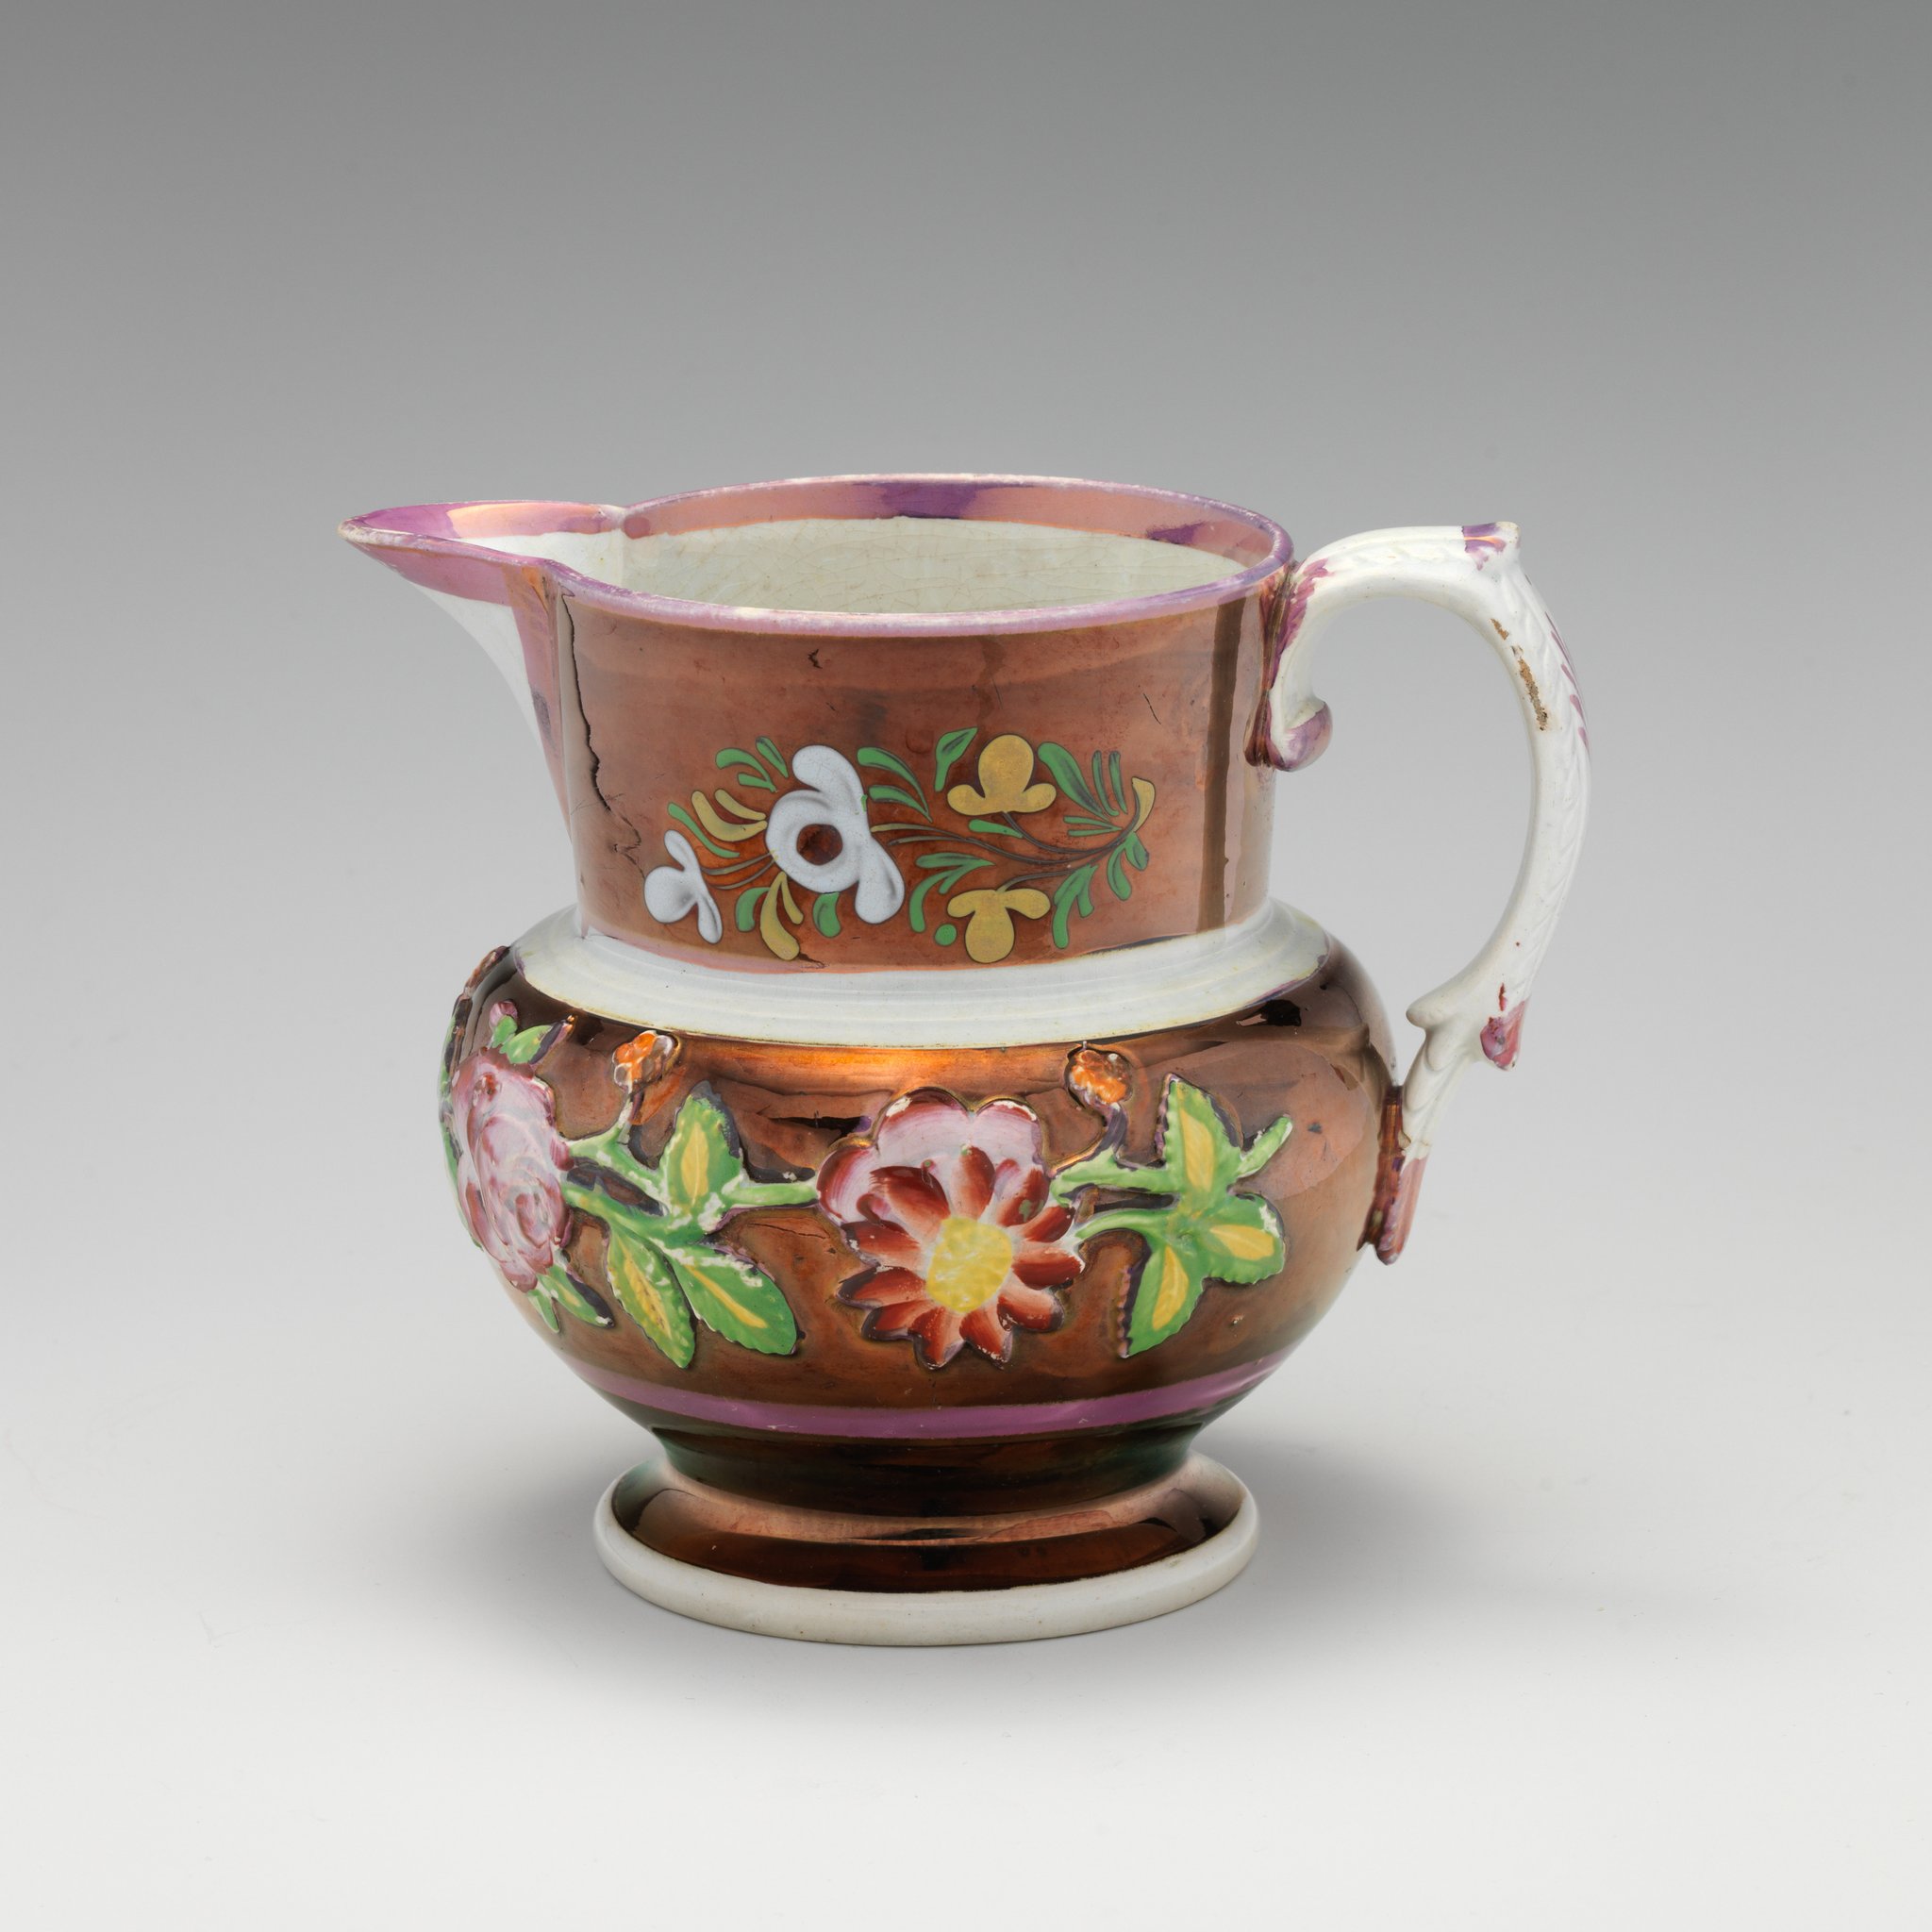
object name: jug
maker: sewell and co.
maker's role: factory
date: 1801-1833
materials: pottery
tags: flowers